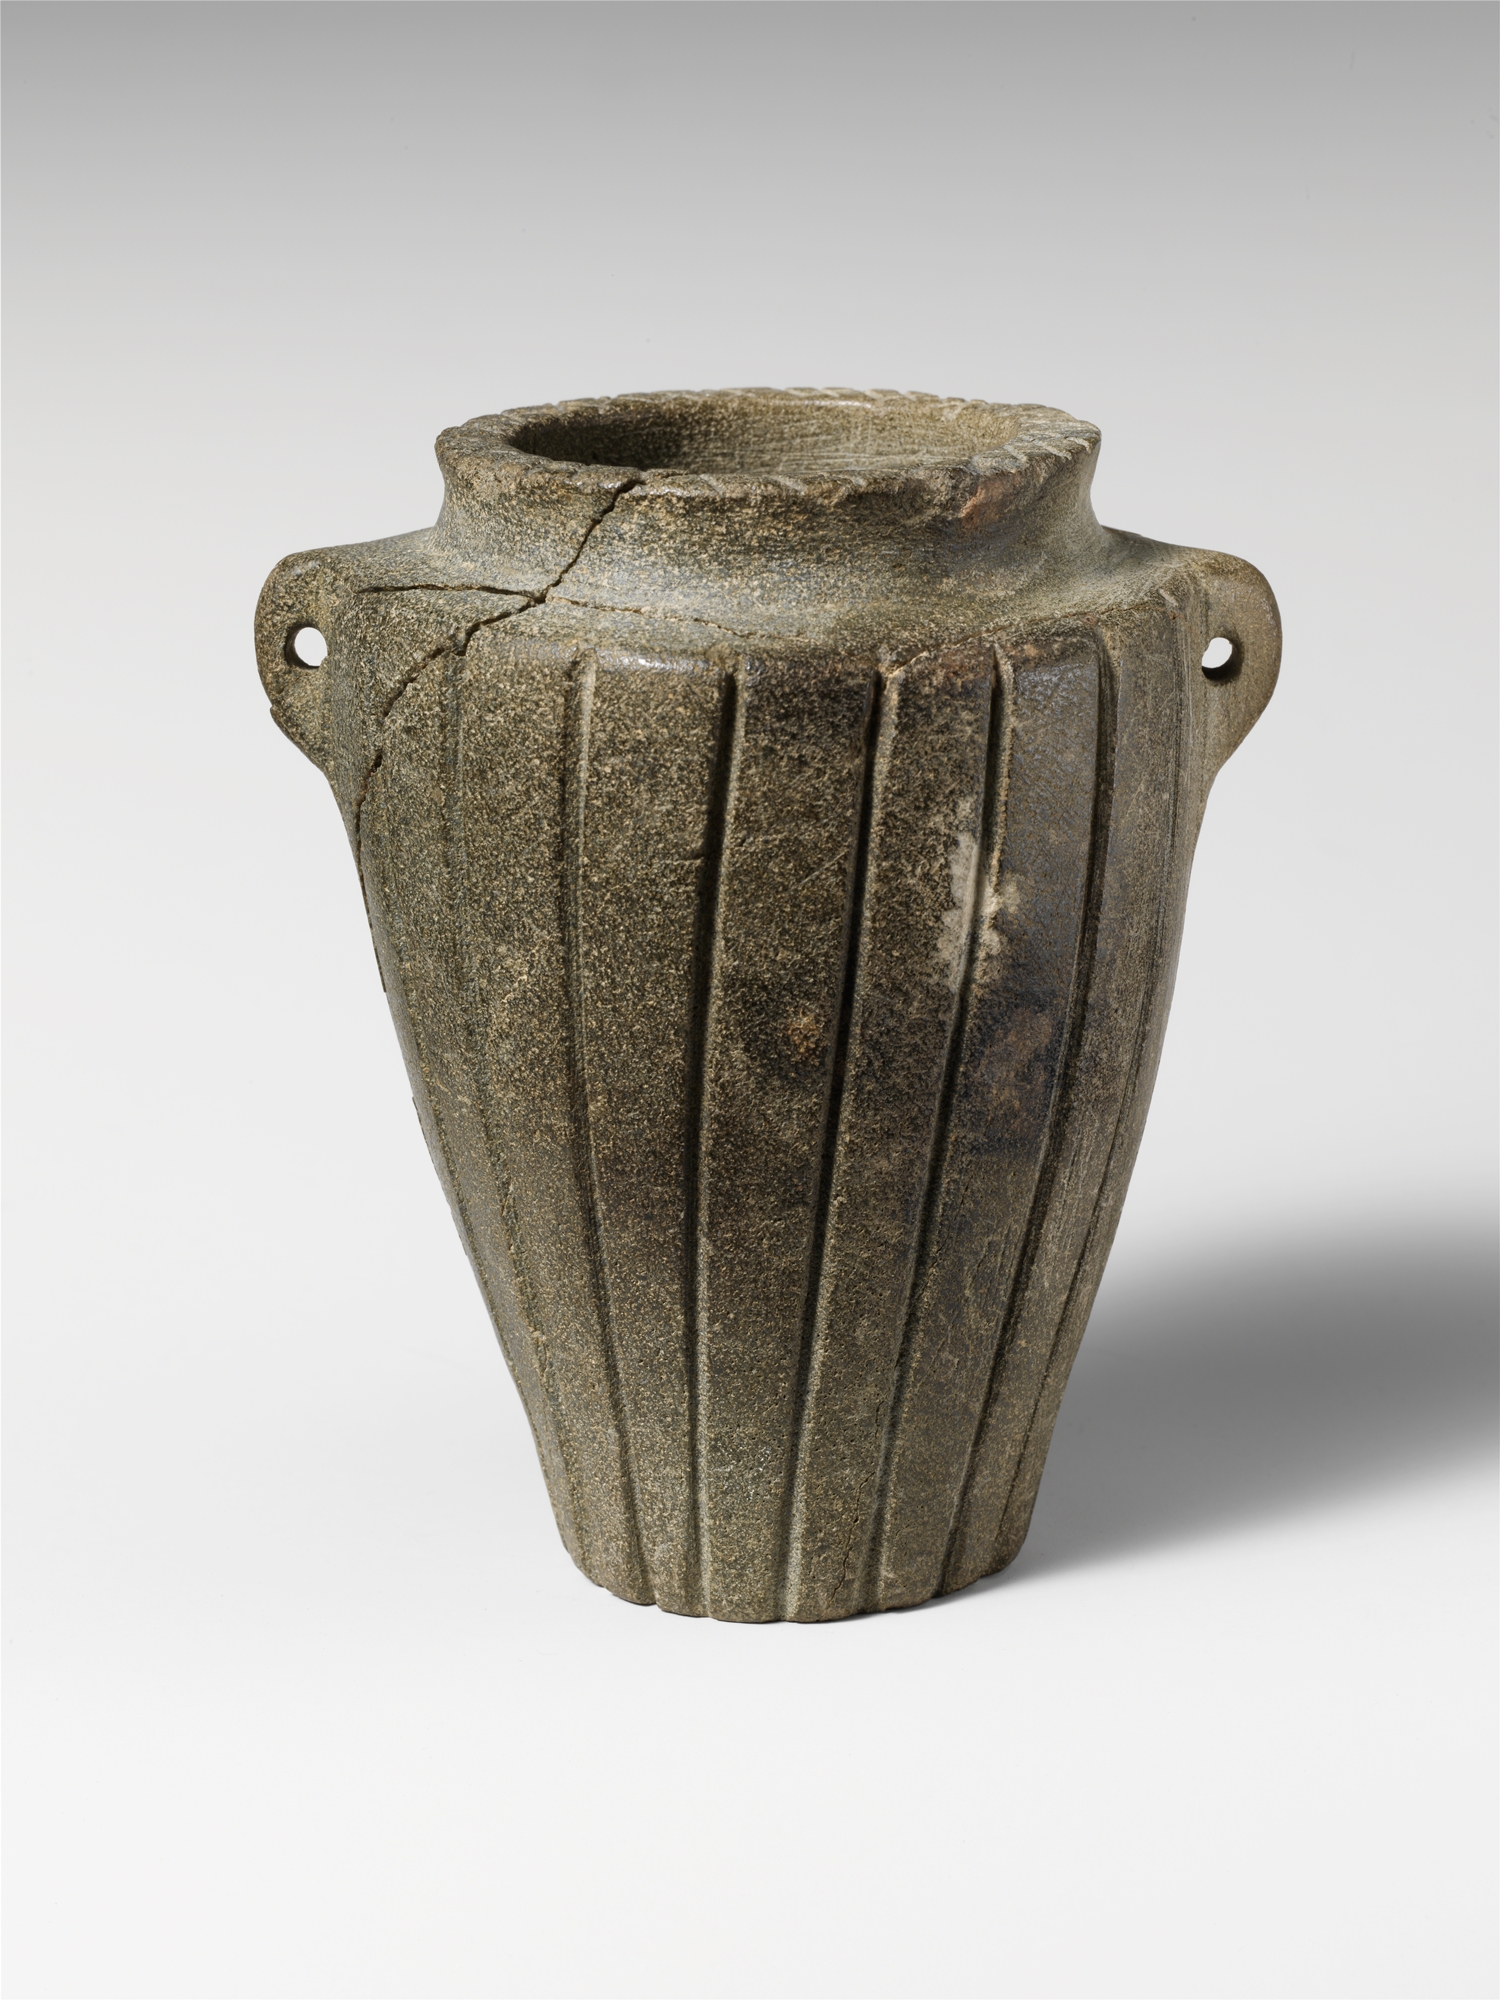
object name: jar, miniature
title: Chlorite miniature jar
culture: cypriot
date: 1600-1050 BCE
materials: mineral